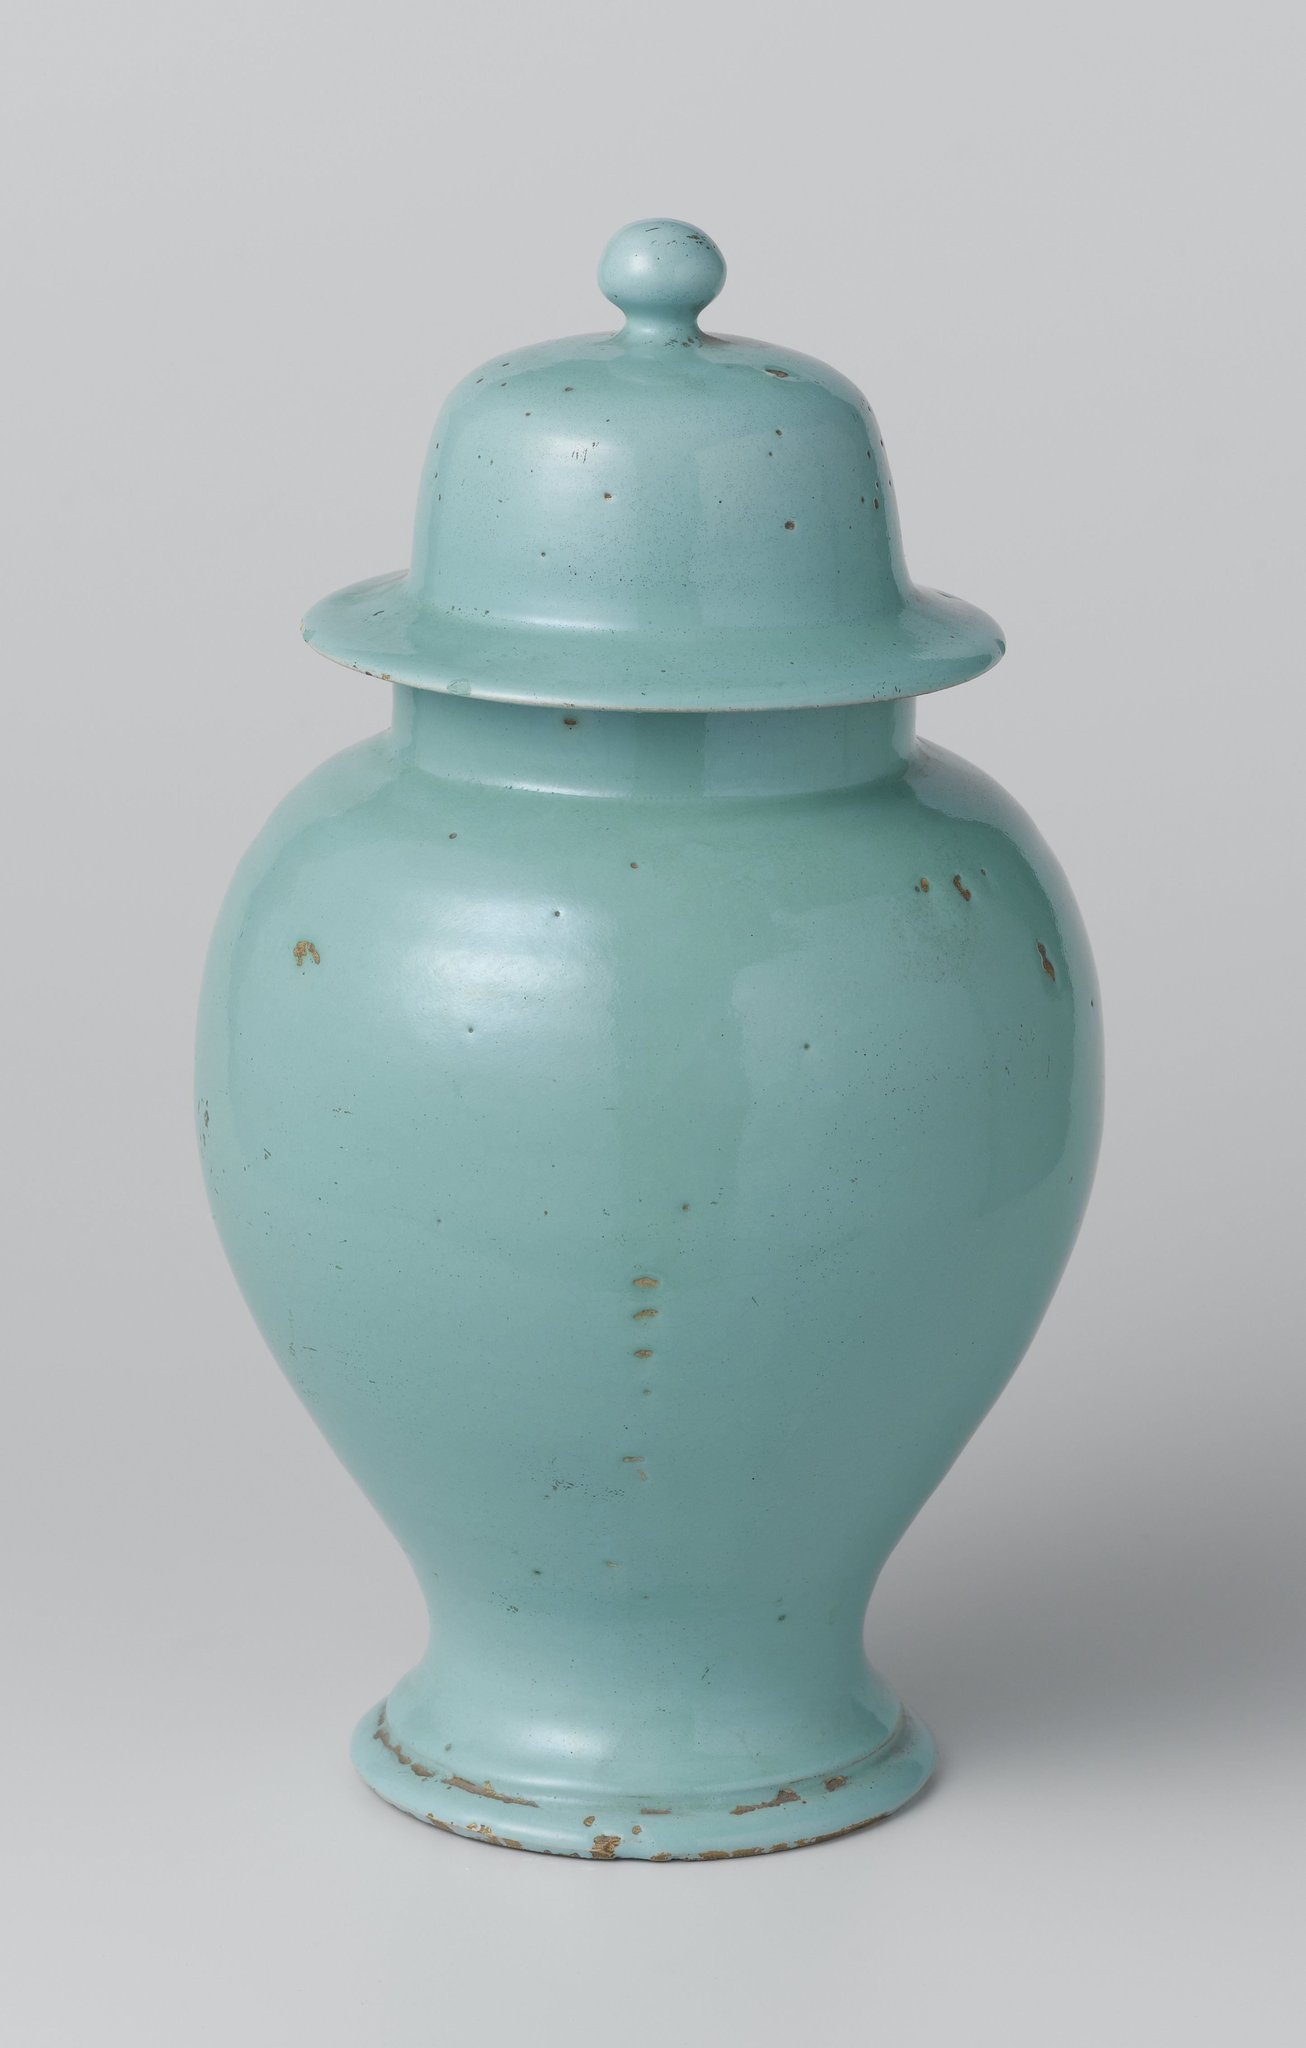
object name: covered jar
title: Dekselpot van faience met blauwgroen fond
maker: Anonymous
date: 1700-1750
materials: earthenware, glaze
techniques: painted, polychromy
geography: delft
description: Pot van veelkleurig beschilderde faience op een blauwgroene fond. De pot is onderdeel van een stel. Bij de pot horentwee identieke potten en twee bekers.